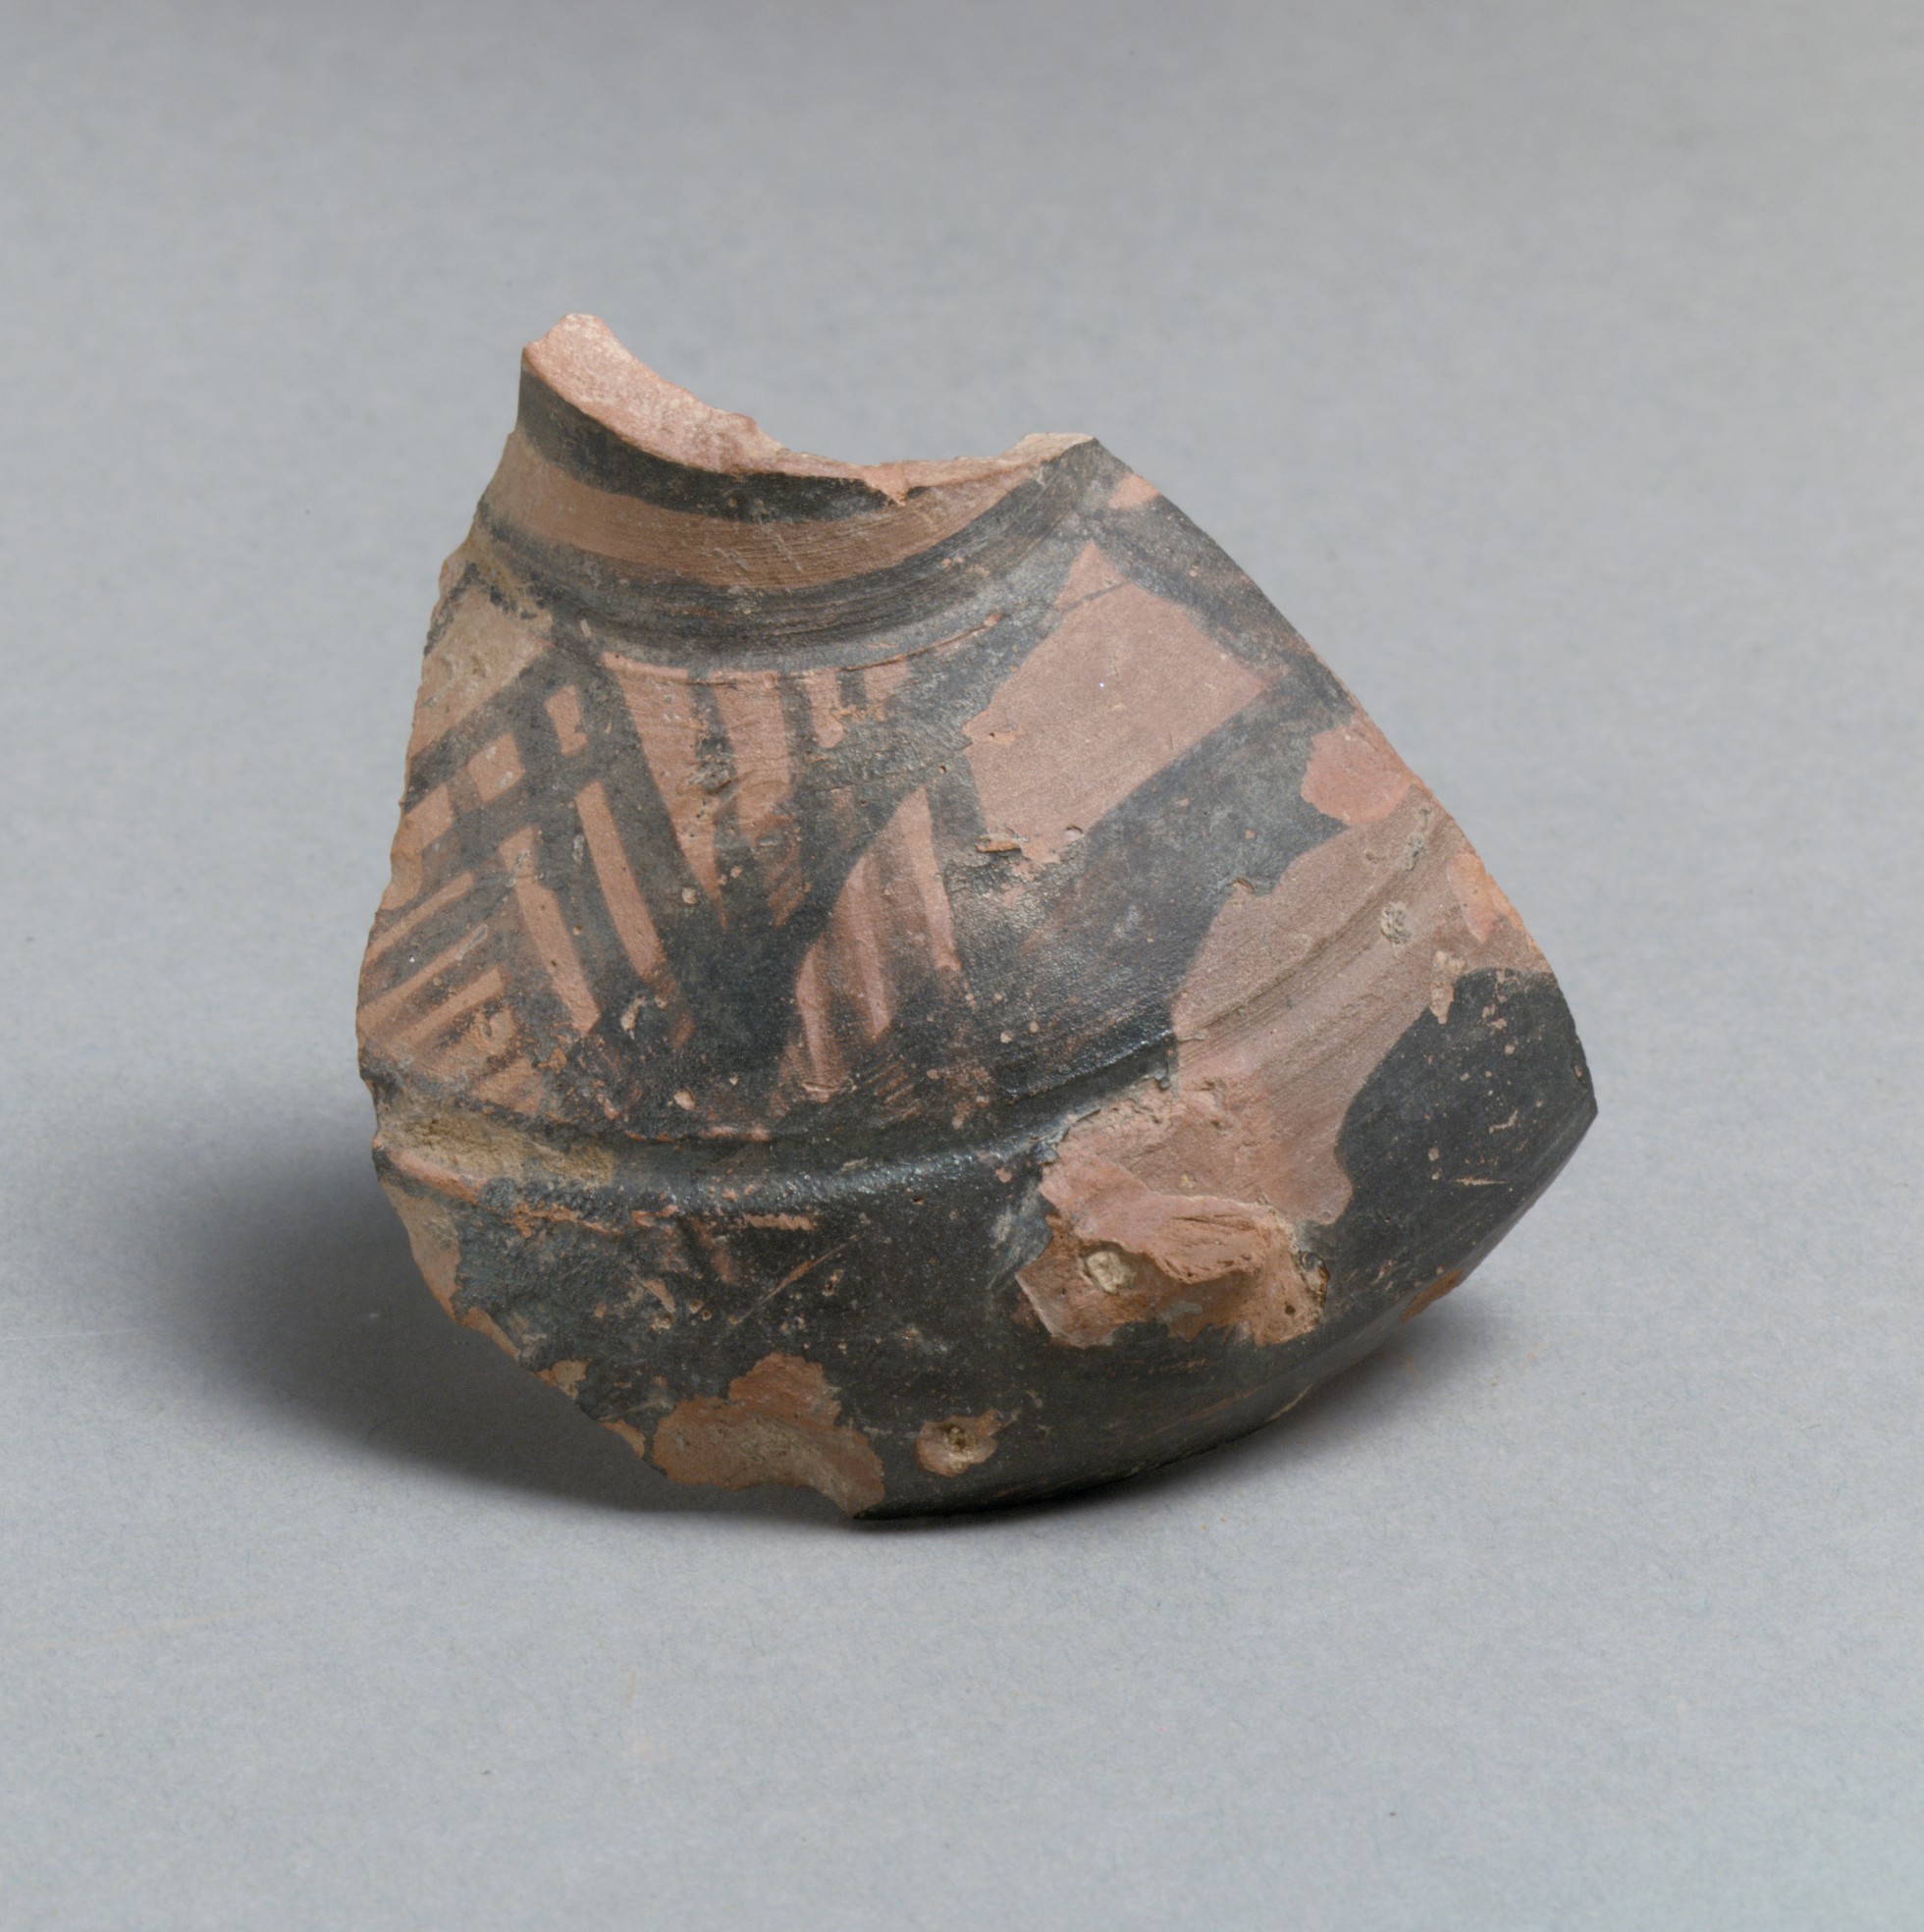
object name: vase fragment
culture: greek, laconian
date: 2000-1550 BCE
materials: terracotta